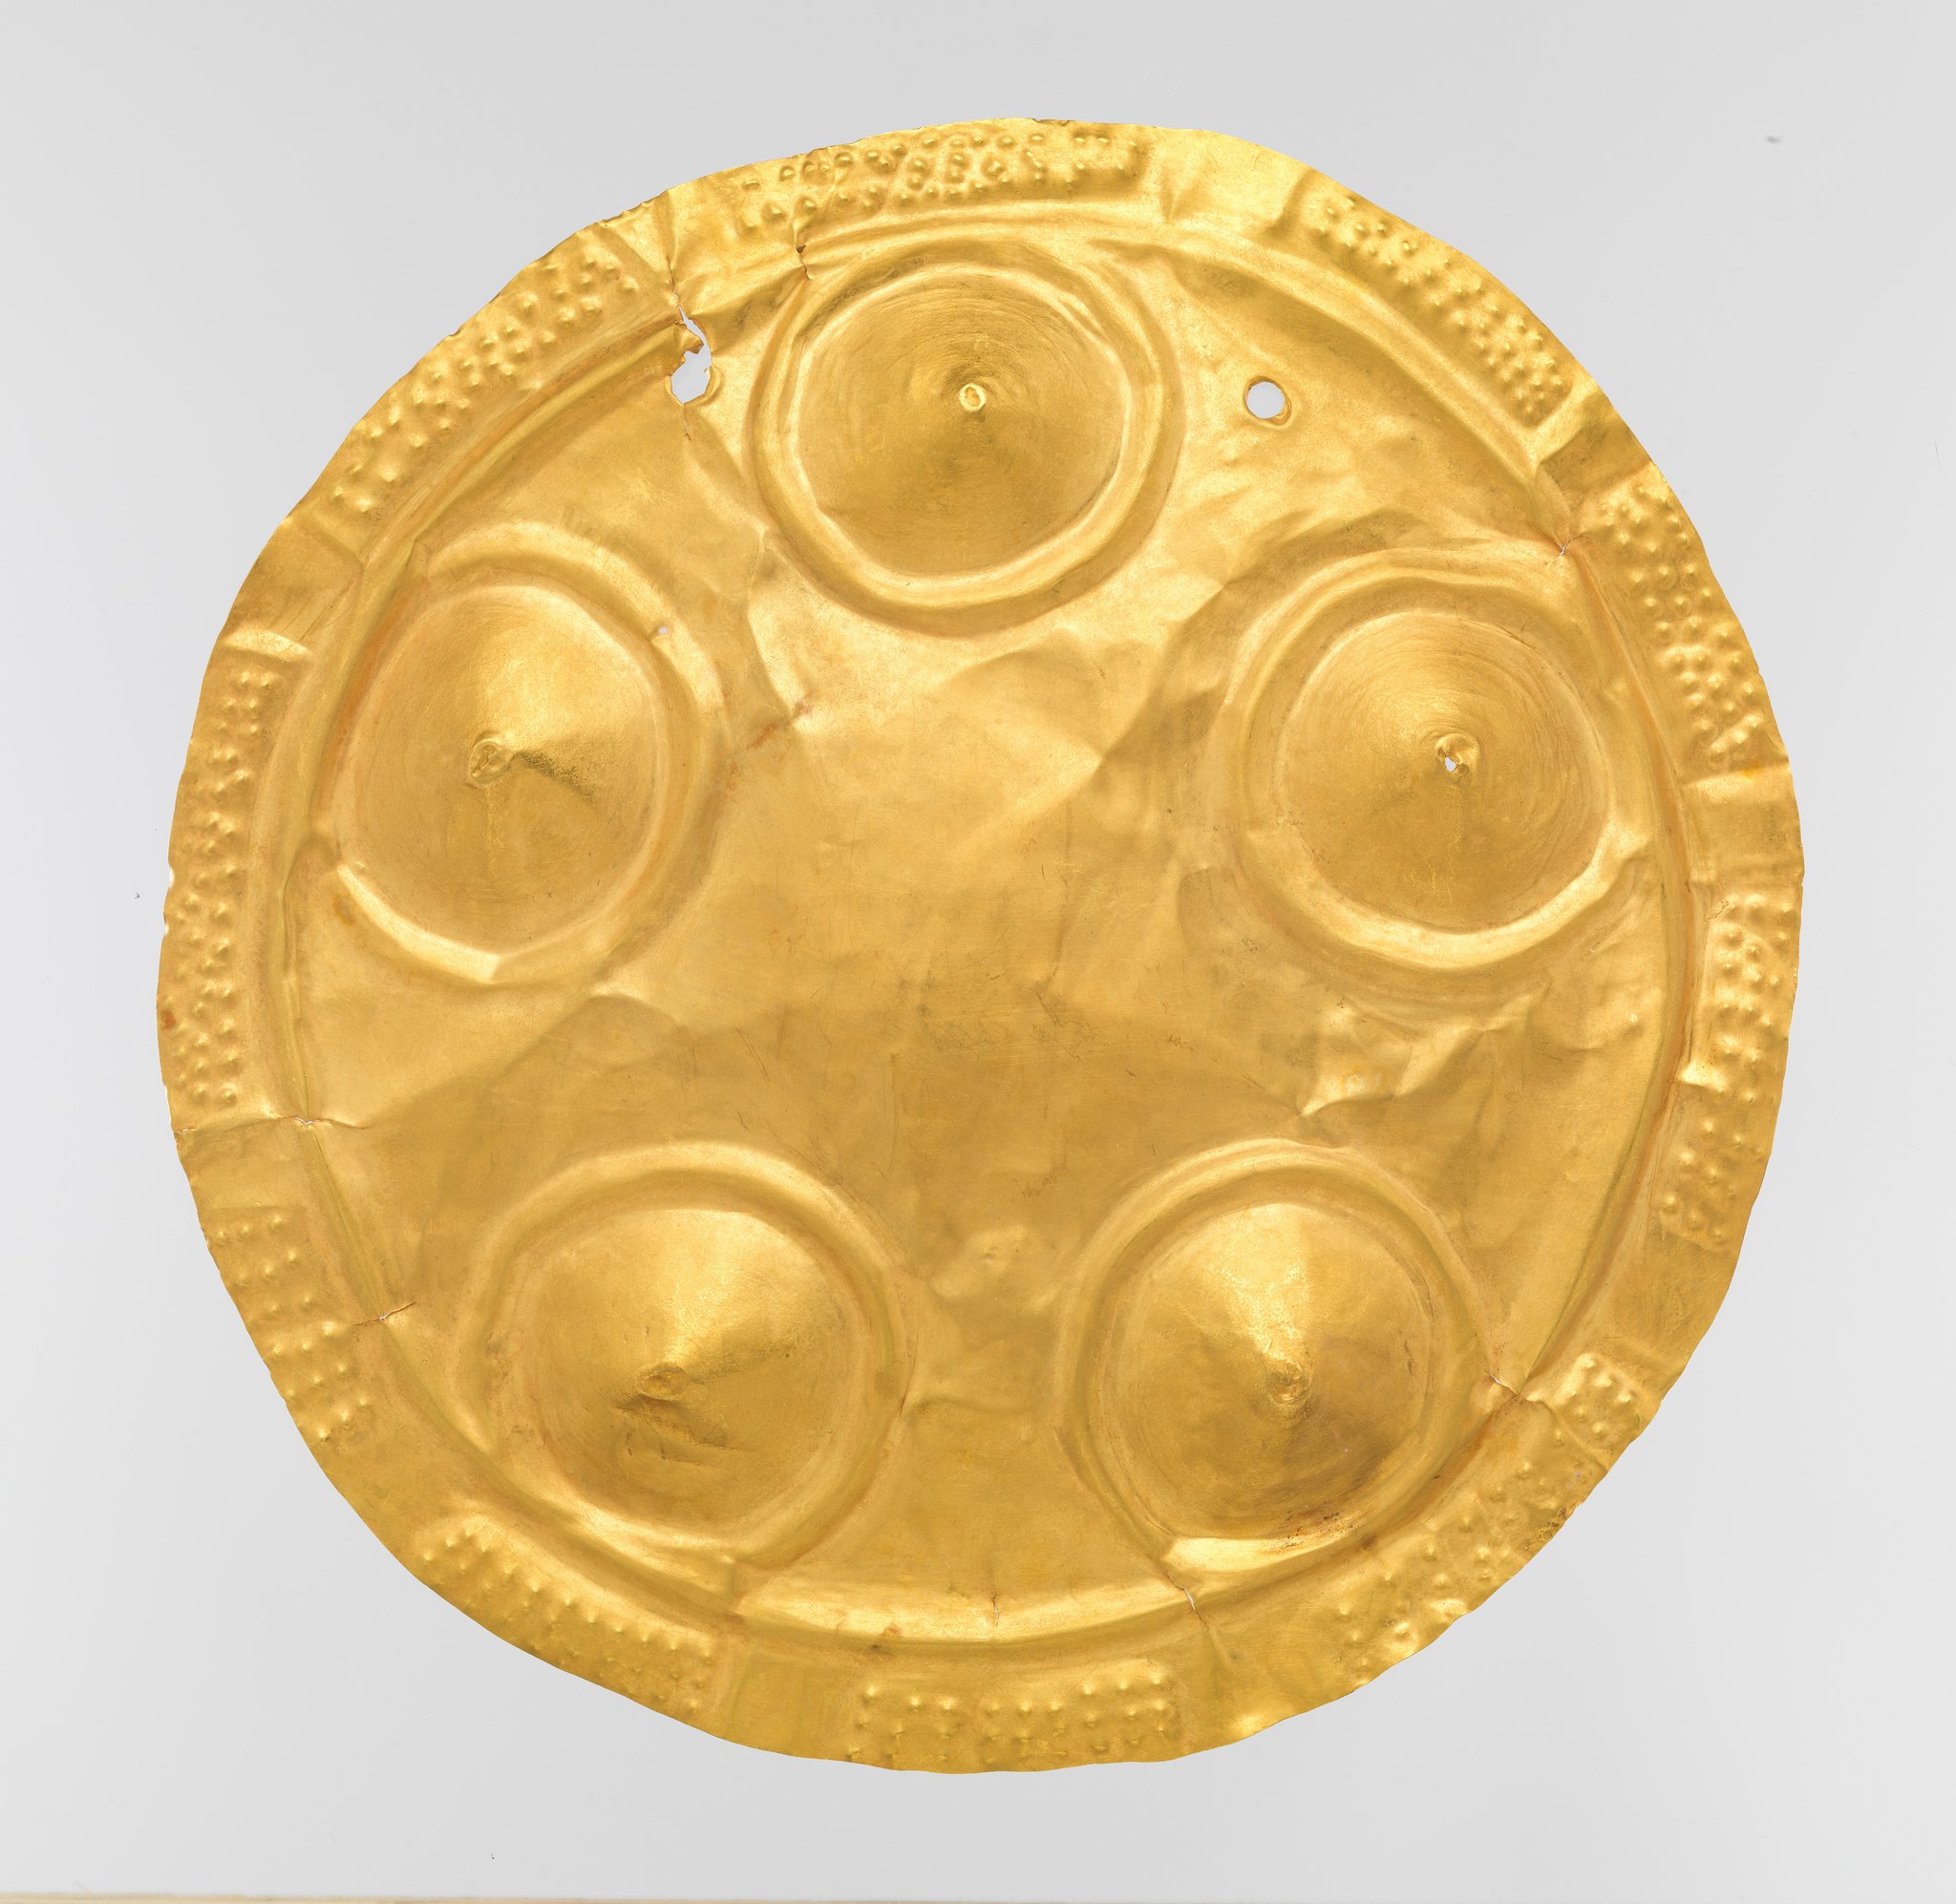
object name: pectoral disk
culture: veraguas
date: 1001-1600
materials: gold, leather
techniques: hammering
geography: panama